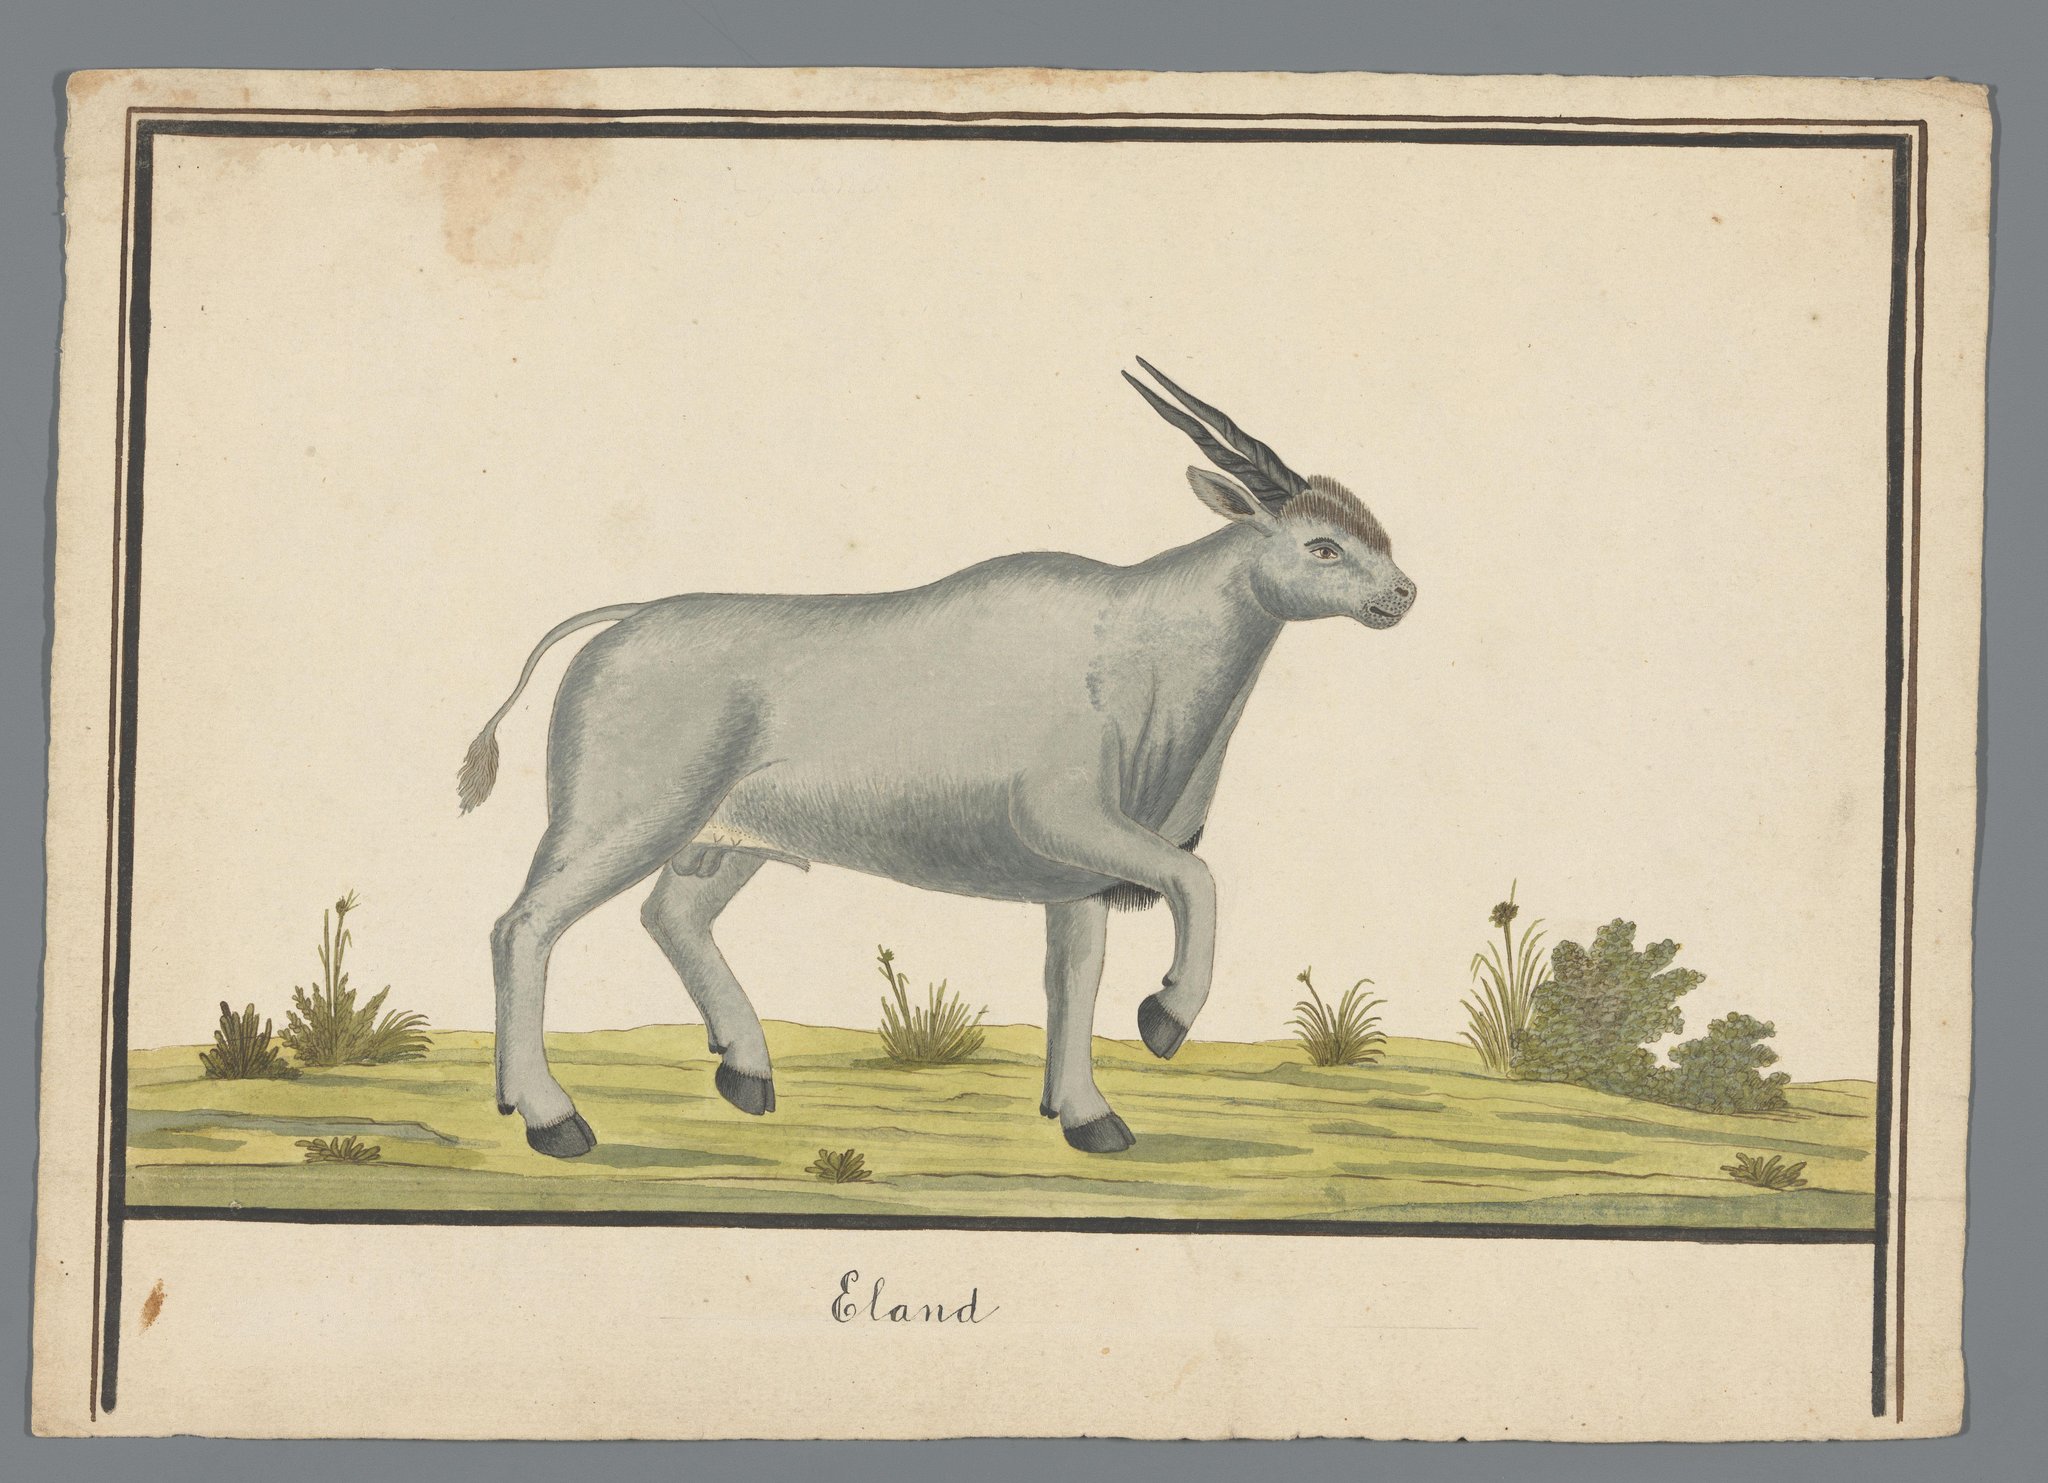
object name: drawing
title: Eland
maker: johannes schumacher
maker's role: draughtsman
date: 1776-1777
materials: paper, watercolor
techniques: brush, pen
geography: south africa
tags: hoofed animals: antelope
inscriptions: label: ‘20’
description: Een Zuid-Afriikaanse antilope, mogelijk een koedoe. Tekening gemaakt tijdens één van de reizen van Hendrik Swellengrebel door de Kaapkolonie, tussen juli 1776 en januari 1777.